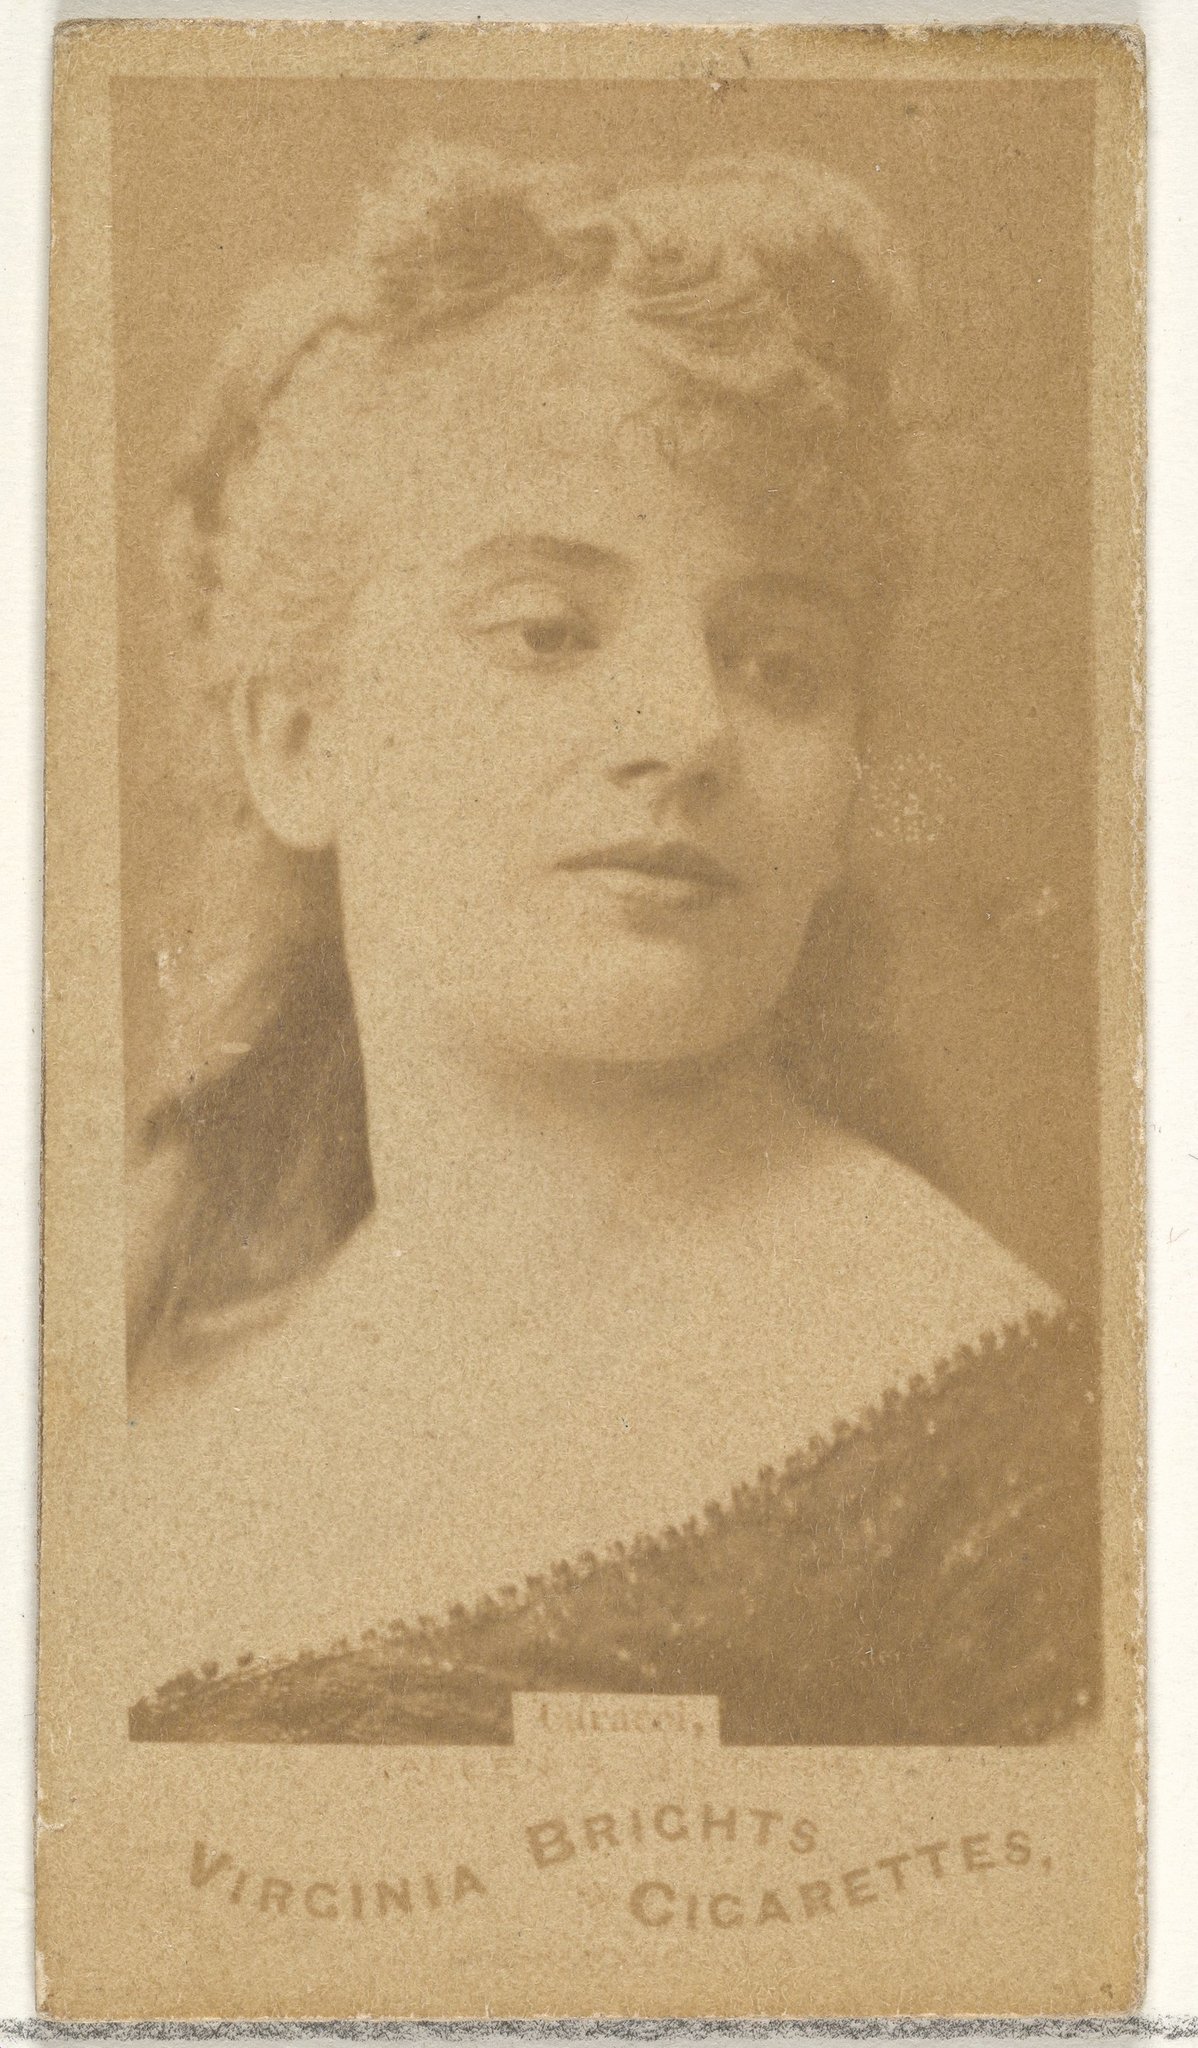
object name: photograph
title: Caracol, from the Actors and Actresses series (N45, Type 1) for Virginia Brights Cigarettes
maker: allen & ginter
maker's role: publisher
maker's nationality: american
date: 1888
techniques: albumen silver print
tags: portraits,women,actresses